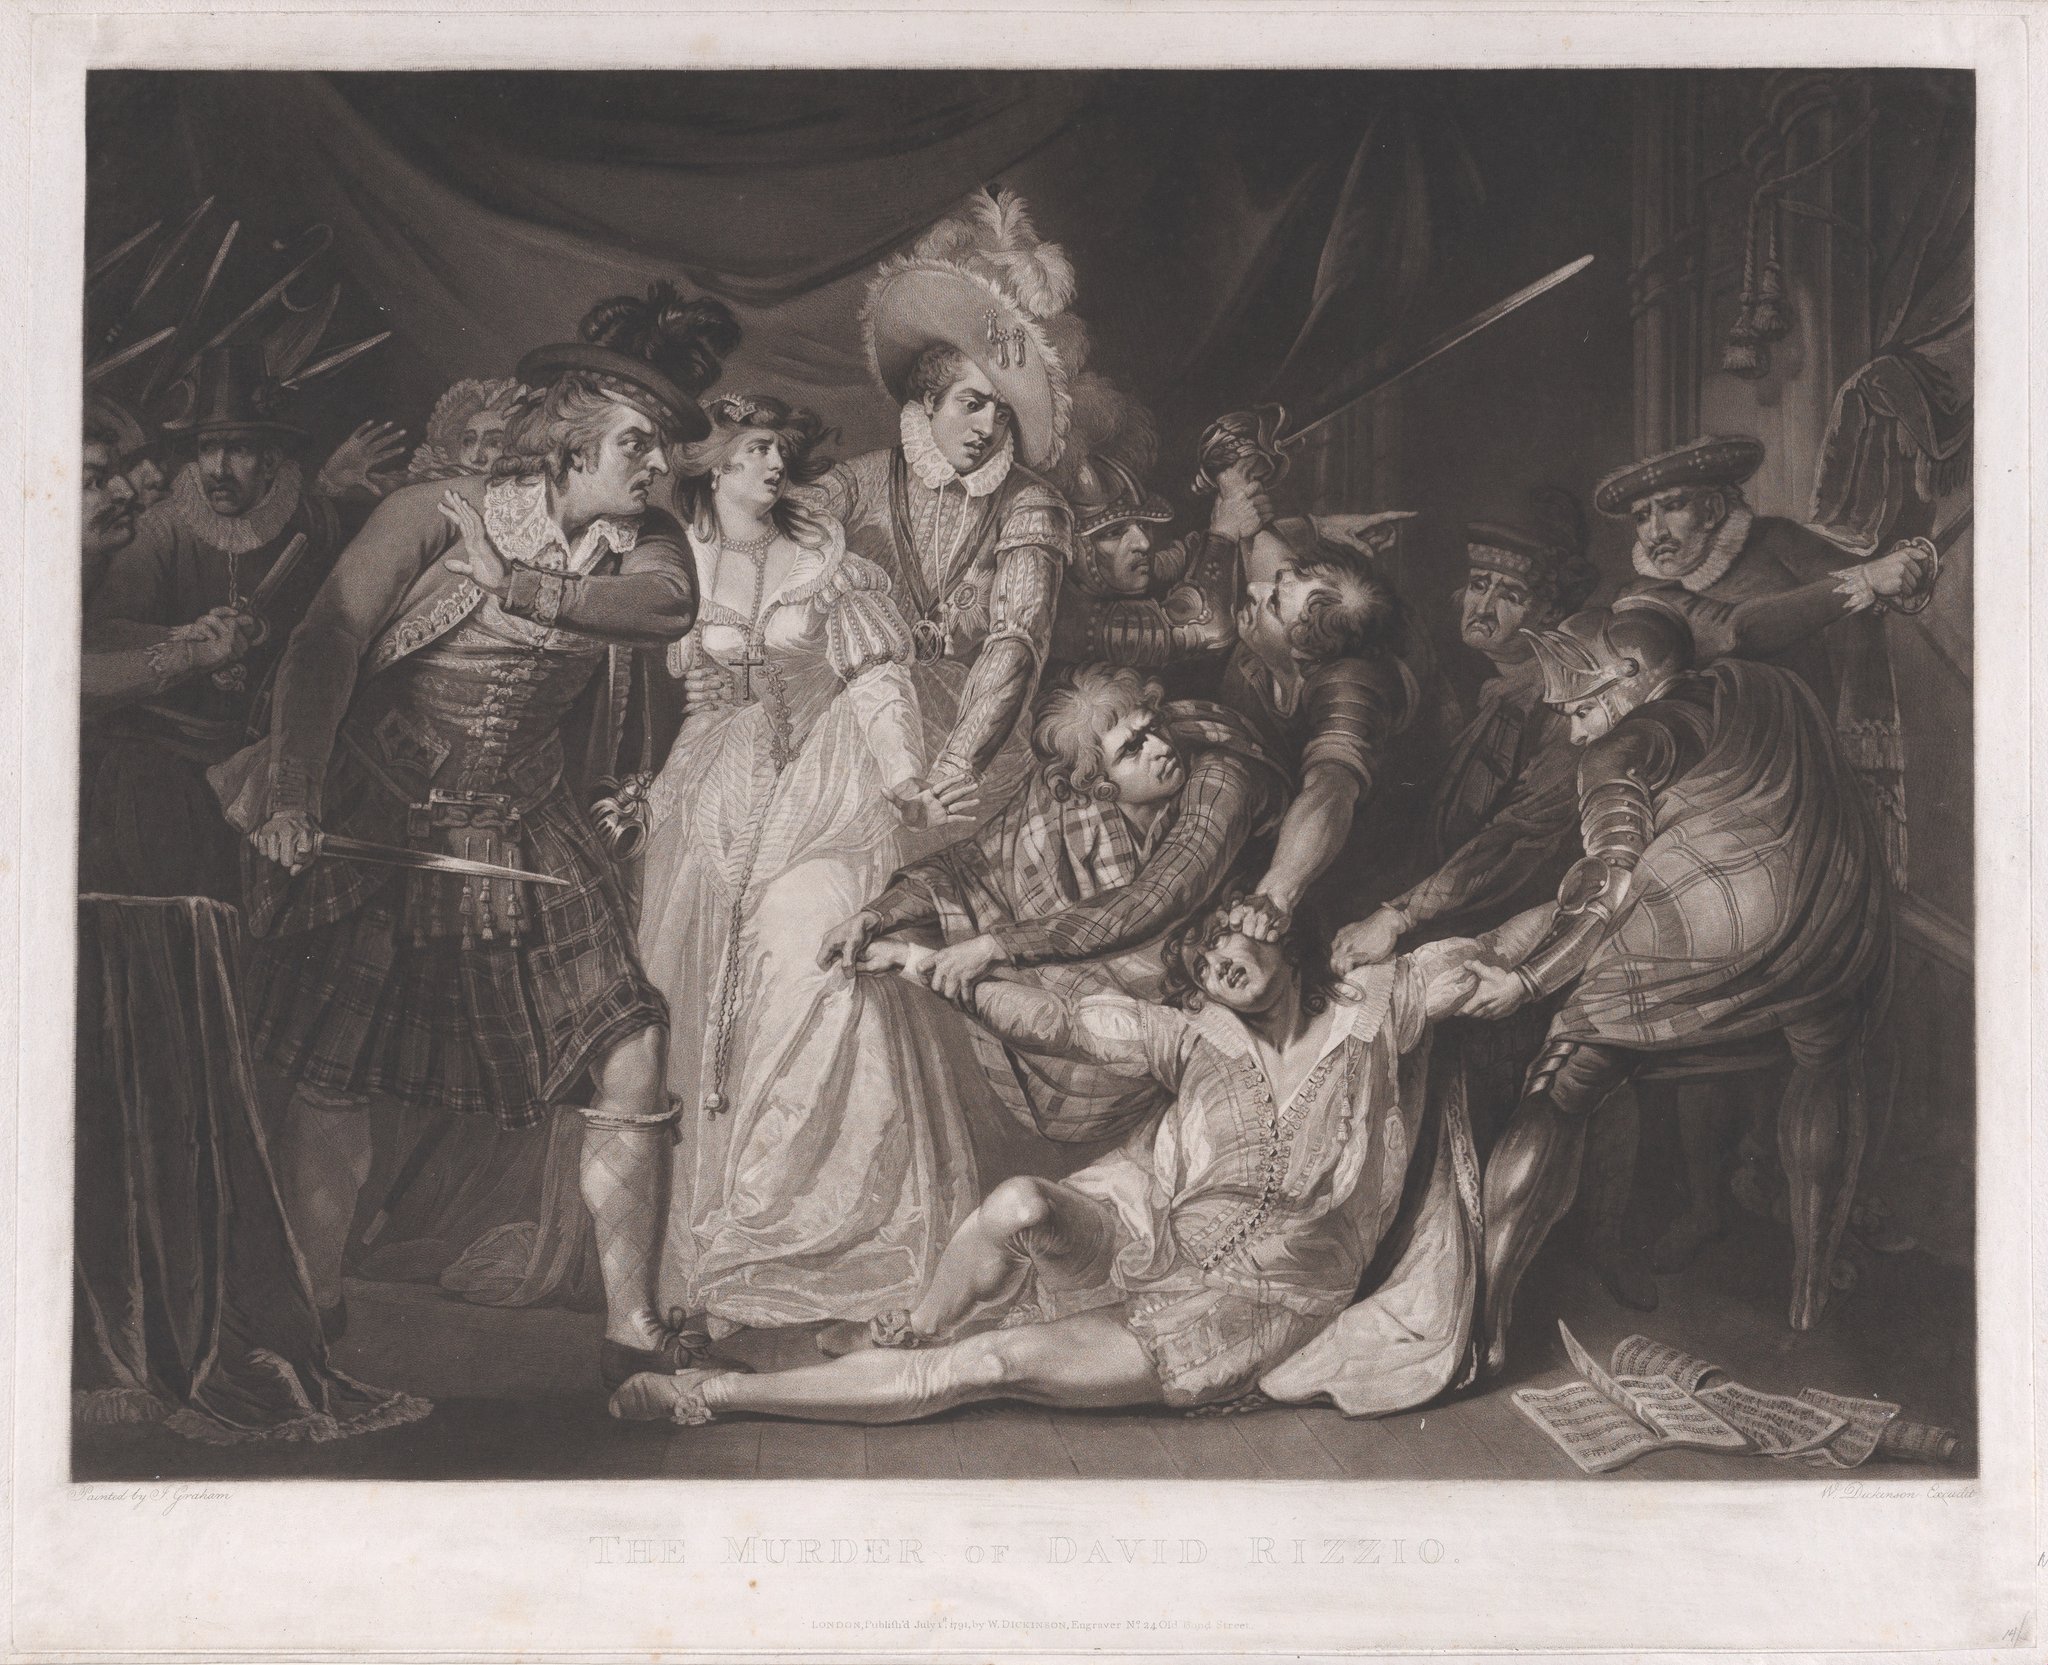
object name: print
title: The Murder of David Rizzio (Mary, Queen of Scots witnessing the murder of David Rizzio)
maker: william dickinson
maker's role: artist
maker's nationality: british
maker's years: 1746-1823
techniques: mezzotint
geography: england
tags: swords,queens,men,women,mary queen of scots